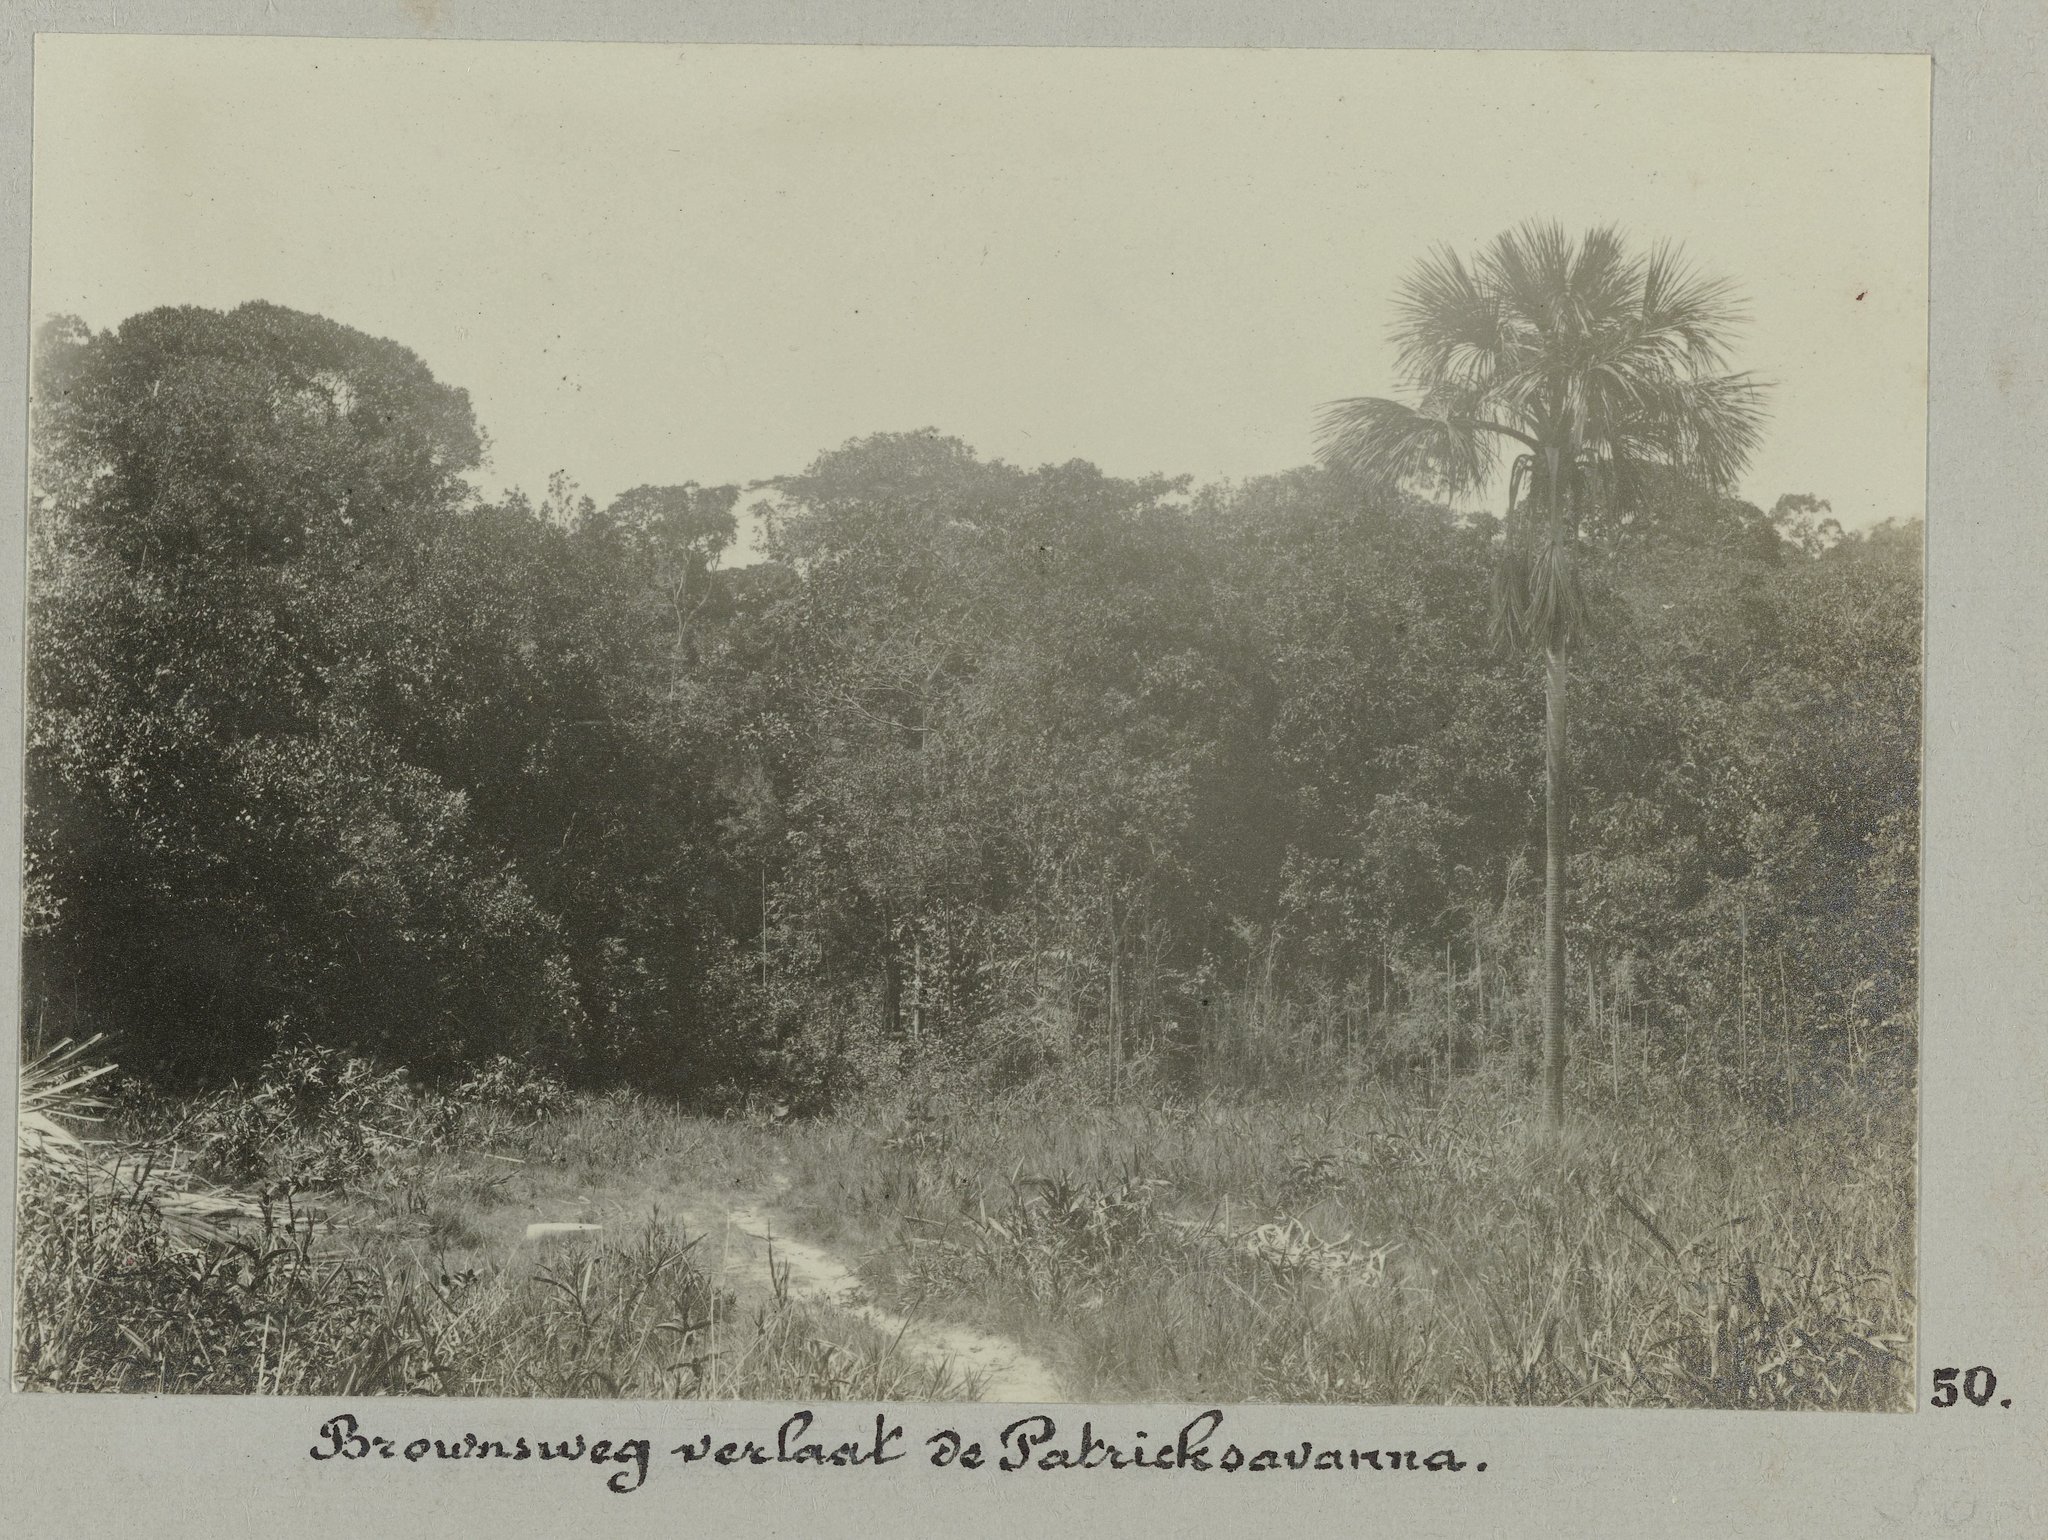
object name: photograph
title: Brownsweg verlaat de Patricksavanna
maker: hendrik doijer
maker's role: engineer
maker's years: 1863-1925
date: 1903-1910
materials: photographic support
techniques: gelatin silver print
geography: suriname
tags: suriname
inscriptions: inscription: ‘50. / Brownsweg verlaat de Patricksavanna.’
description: Een pad, genaamd de Brownsweg, die vanuit de Patrick-savanna het bos in loopt. Onderdeel van het fotoalbum Souvenir de Voyage (deel 2), over het leven van de familie Doijer in en rond de plantage Ma Retraite in Suriname in de jaren 1903-1910.